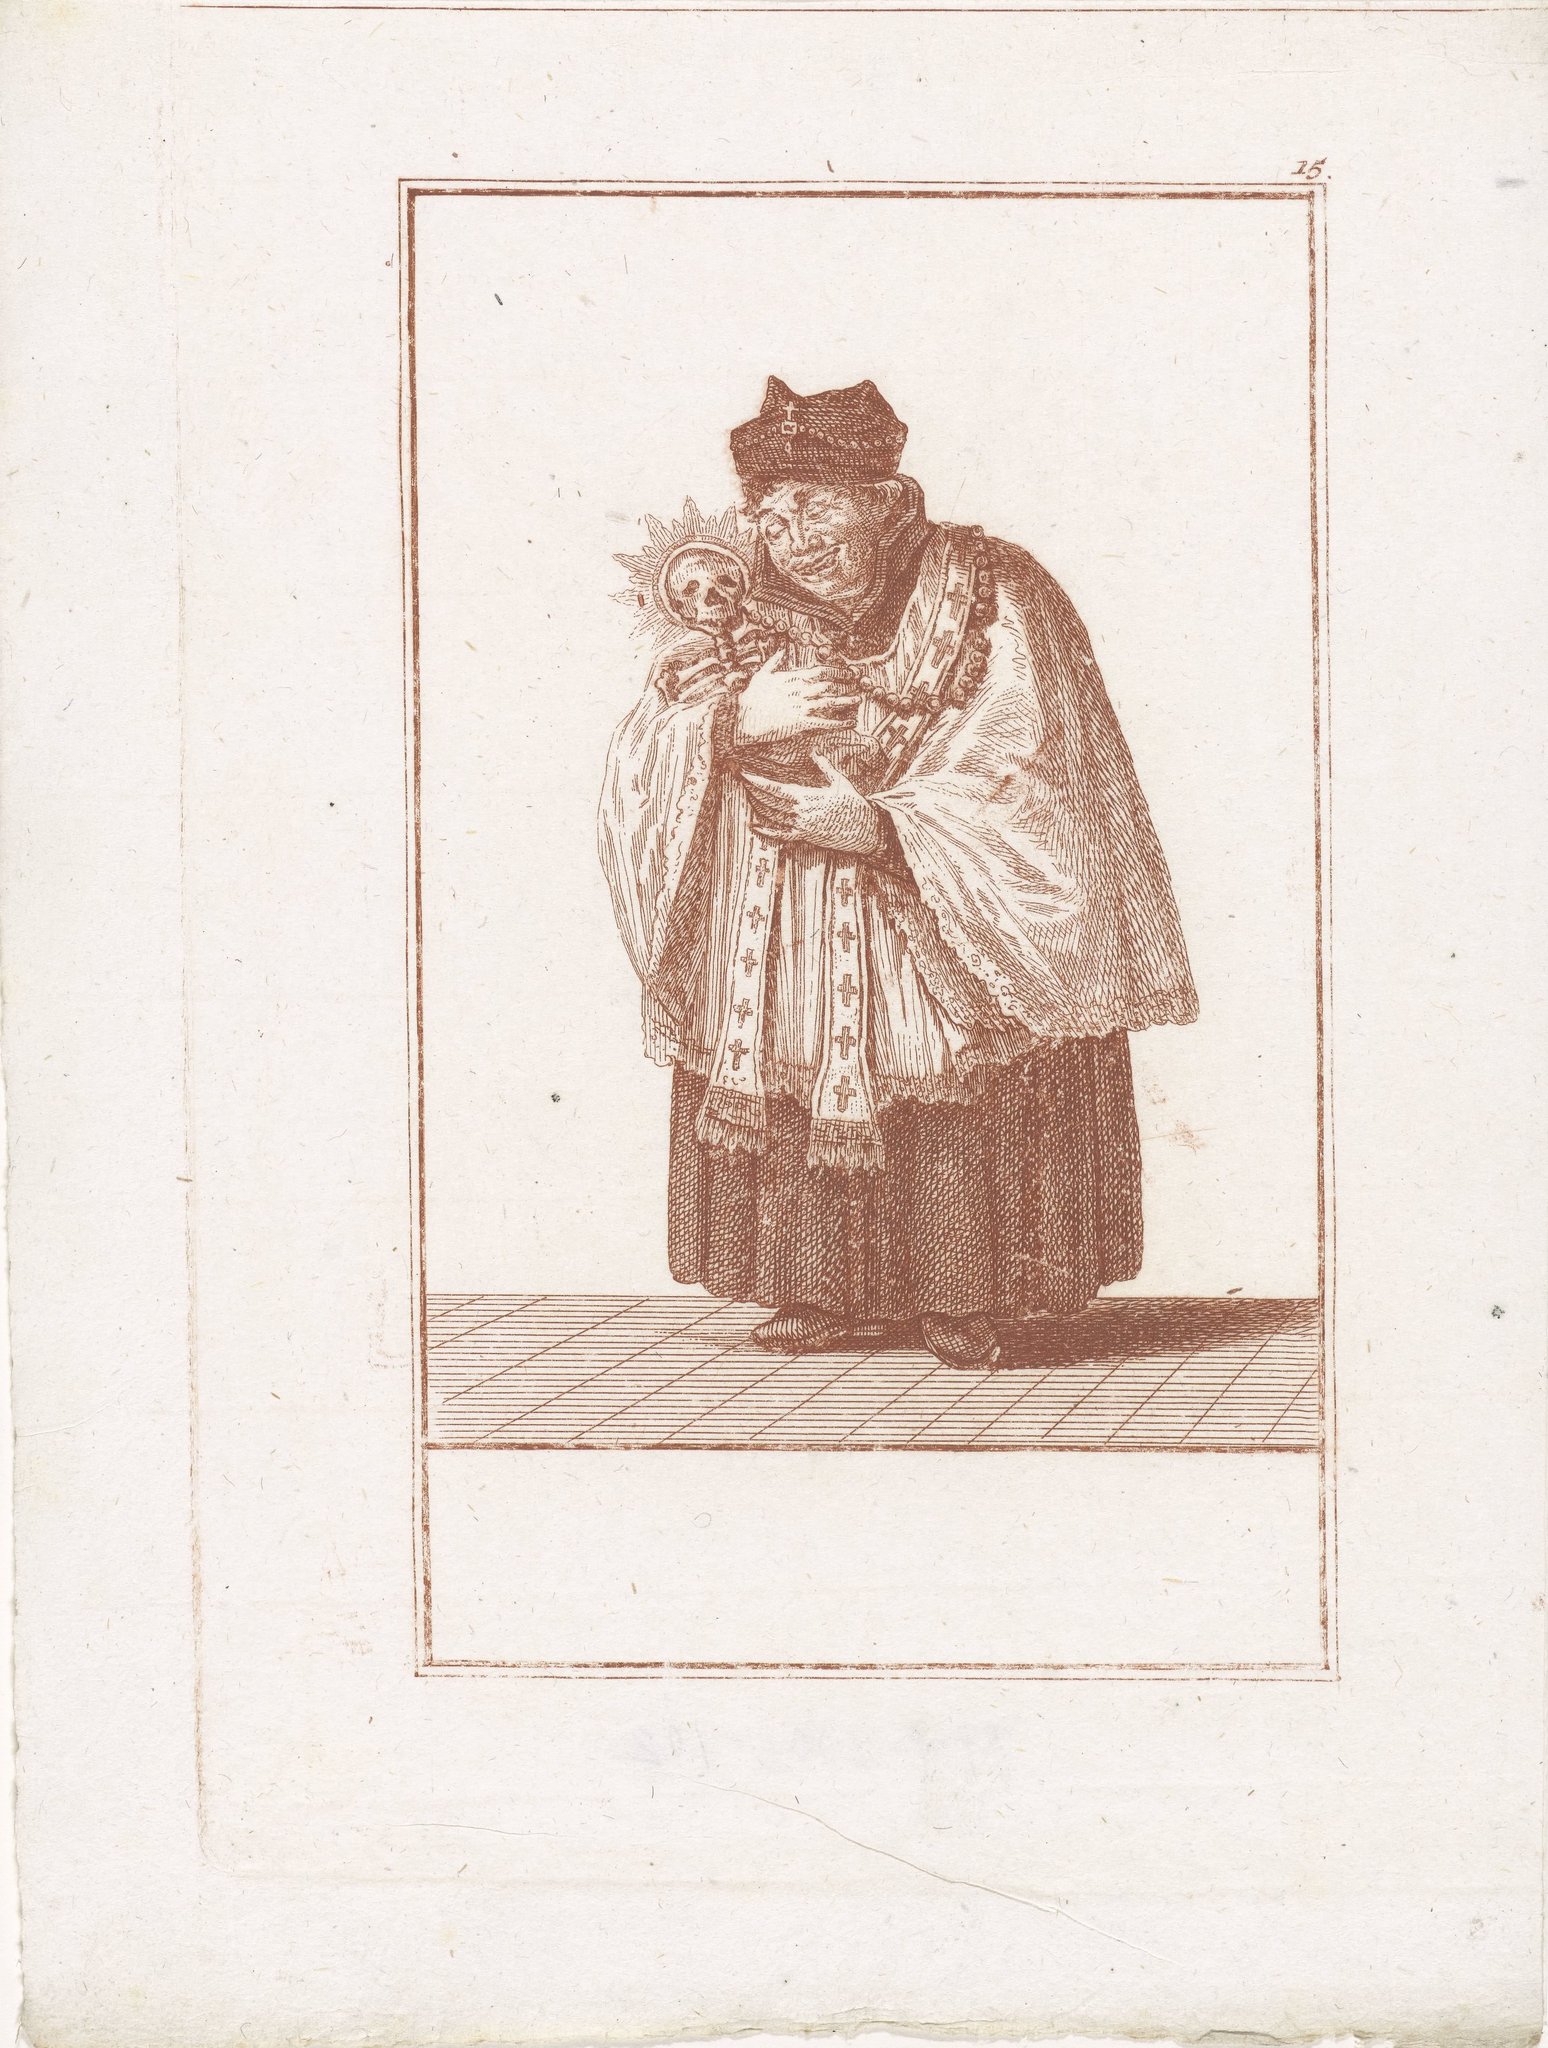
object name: print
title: Priester omarmt monstrans met doodshoofd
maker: jacob gole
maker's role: print maker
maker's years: 1660-1724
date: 1724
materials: paper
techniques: etching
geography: amsterdam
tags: fat (human type), priest (roman catholic), ostensorium, monstrance, monk(s), friar(s), (aspects of) christian religion or the church (as institution) ridiculed, criticized, or caricaturized, (human) skeleton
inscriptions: collector's mark: Lugt 2760, collector's mark: Lugt 2228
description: Een dikke priester omarmt een monstrans in de vorm van een skelet. De prent is deel van een 50-delige serie met als onderwerp de misbruiken van de katholieke geestelijkheid.